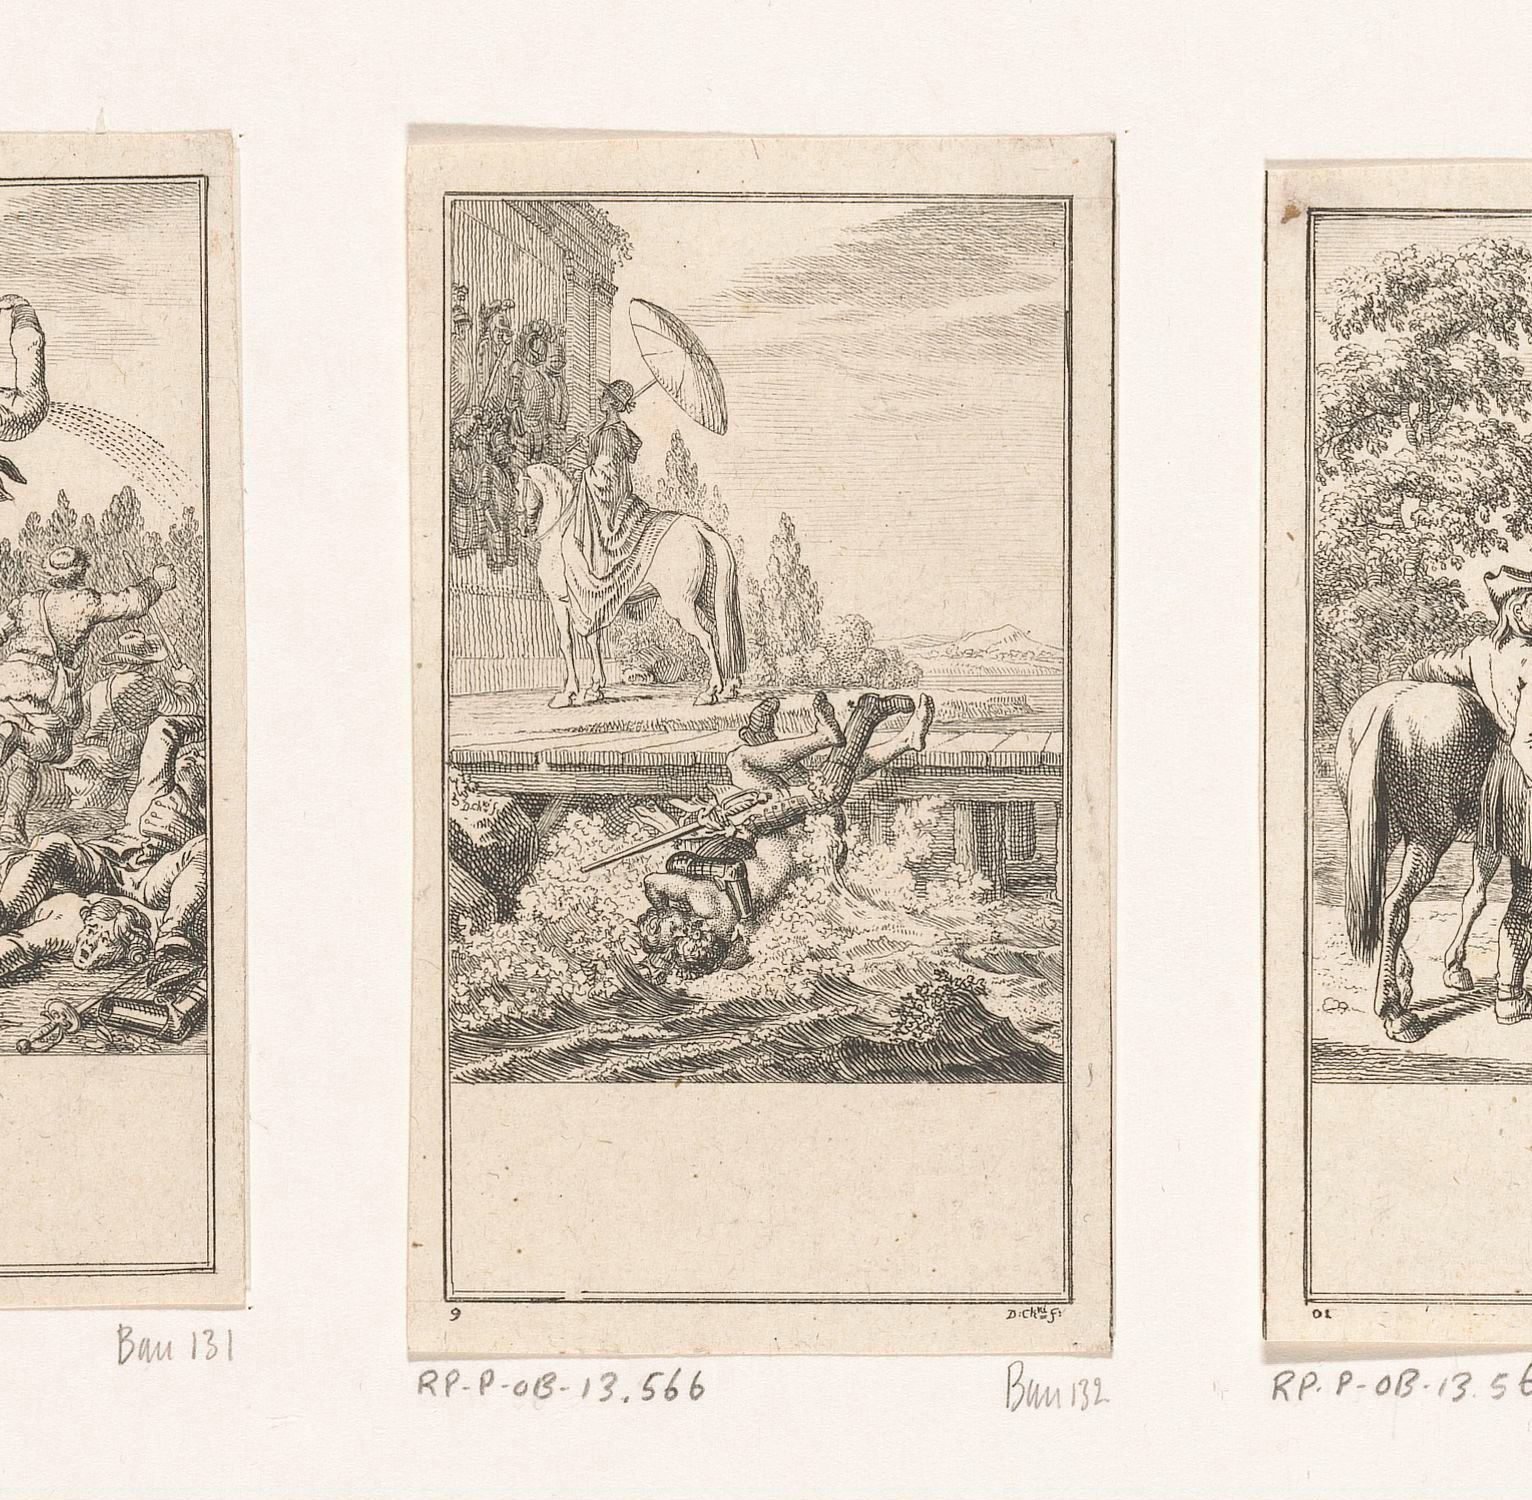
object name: print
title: Ariosto en Rodomonte vallen in het water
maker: daniel nikolaus chodowiecki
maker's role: draughtsman, print maker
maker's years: 1726-1801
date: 1771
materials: paper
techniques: etching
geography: berlin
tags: ludovico ariosto, 'tropaion', i.e. decorative ornament ~ weapons, bridge, fighting, (scenes from) specific works of literature: ariosto, orlando furioso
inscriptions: collector's mark: Lugt 240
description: Canto negenentwintig uit 'Ariosto Furioso'. Ariosto en Rodomonte raken met elkaar in gevecht op de brug die leidt naar het mausoleum dat Rodomonte heeft laten bouwen ter ere van Isabella. De mannen vallen in het water waarna de geharnaste Rodomonte verdrinkt. In de achtergrond bekijkt Fordelis de wapens van door Rodomonte verslagen ridders die aan de muur van het mausoleum zijn bevestigd. Linksonder genummerd: 9.